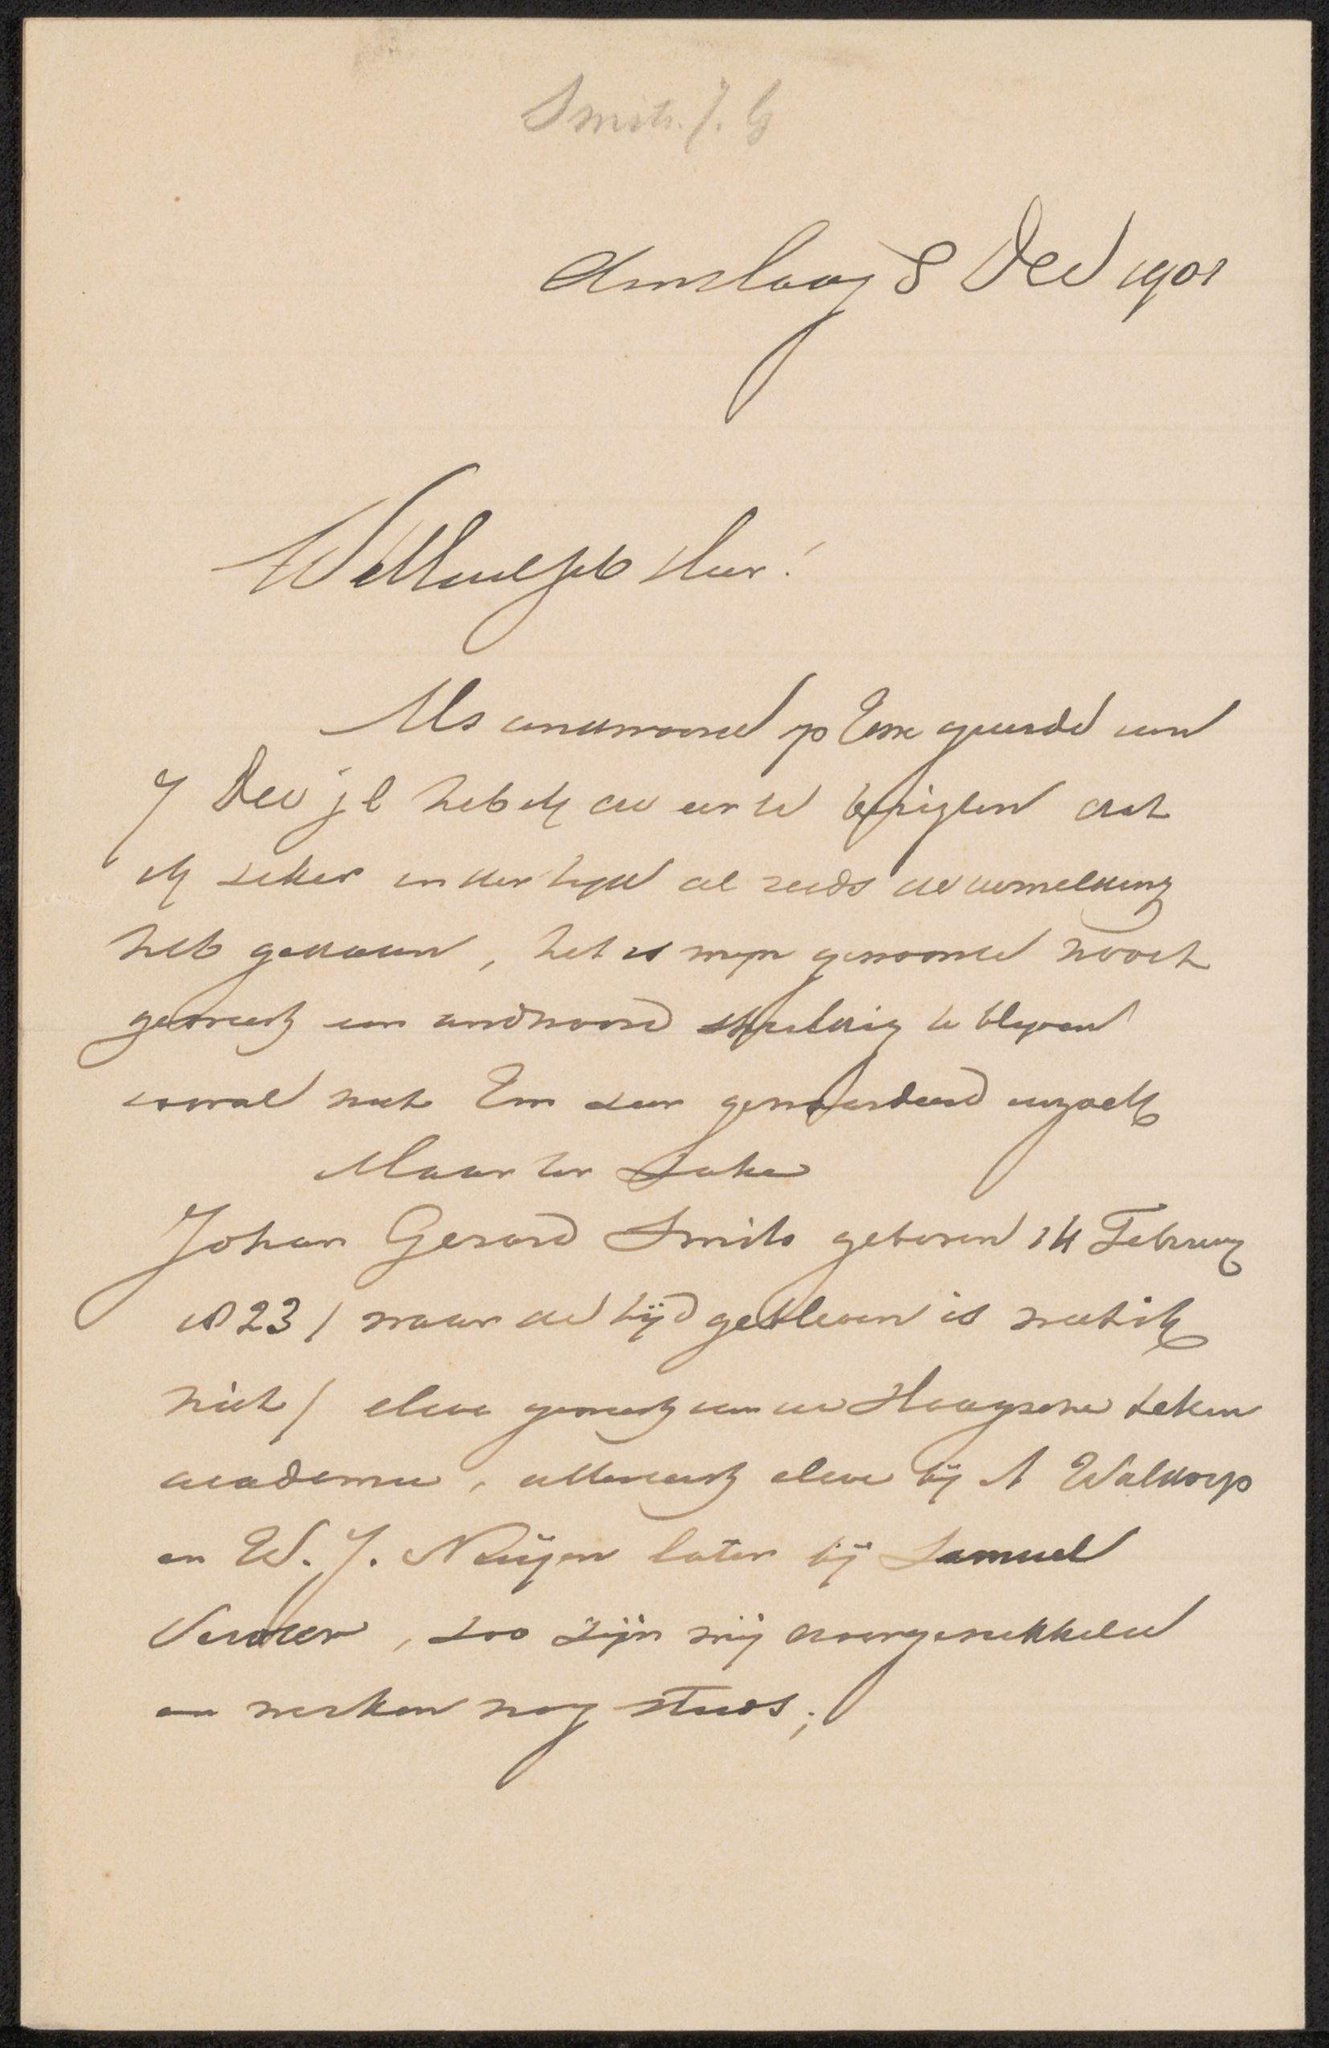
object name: letter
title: Brief aan anoniem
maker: jan gerard smits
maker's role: draughtsman, print maker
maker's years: 1823-1910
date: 1901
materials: ink, paper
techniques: pen, writing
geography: the hague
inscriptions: collector's mark: ‘RPK’